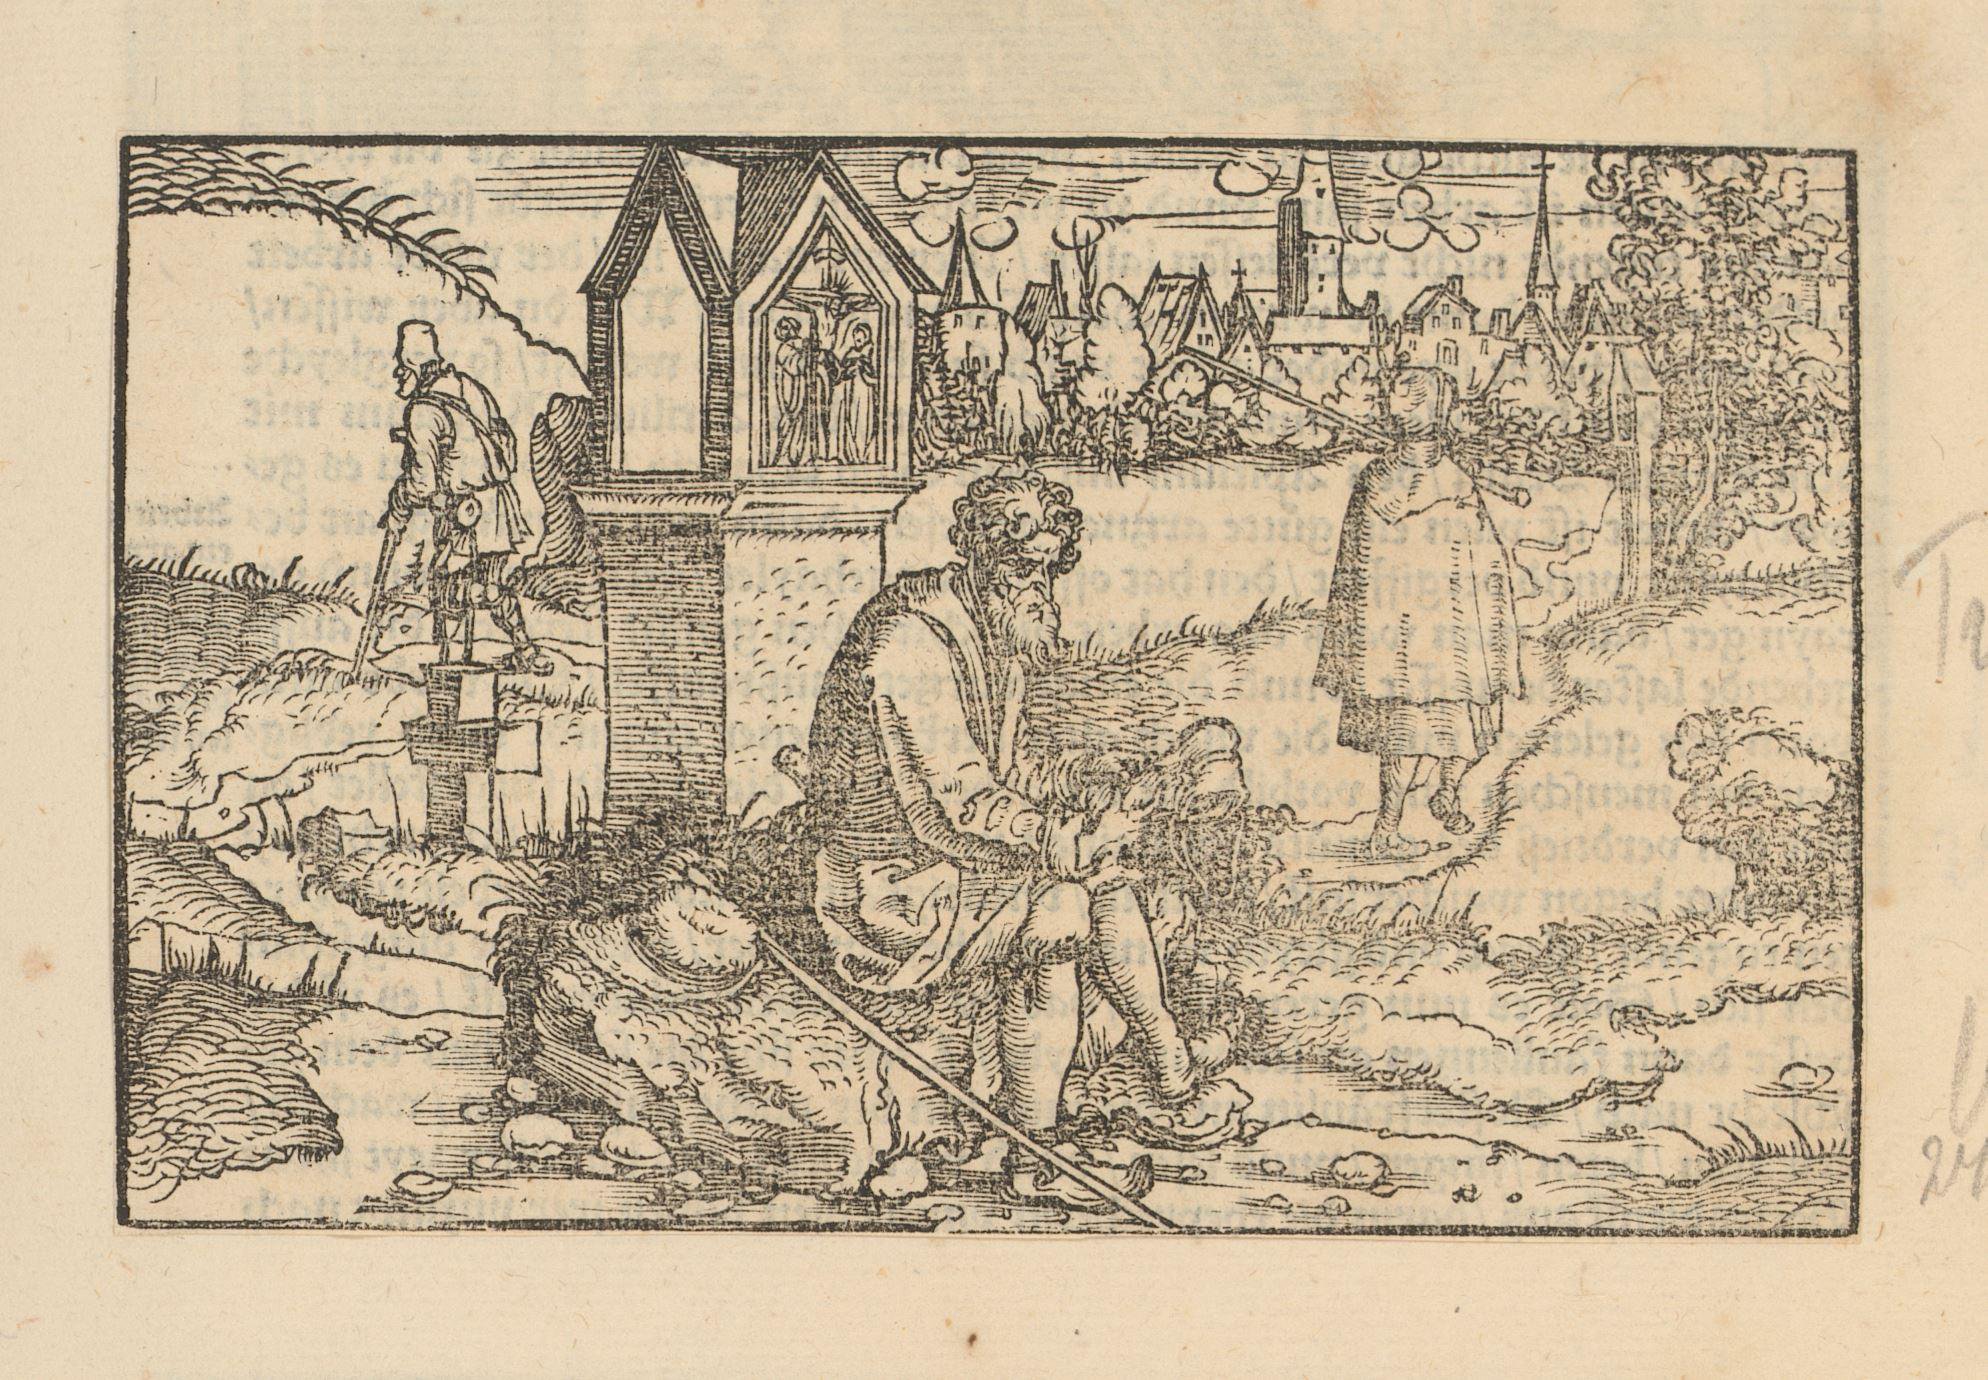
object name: album leaf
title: Reiziger bij een schrijn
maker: Anonymous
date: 1514-1532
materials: paper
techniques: letterpress printing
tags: (traveller) resting in the open air, 'en route', traveller under way, road side shrine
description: Deze prent is gebruikt in: Petrarca, Francesco. Von der Artzney bayder Glück, des guten und widerwertigen: unnd weß sich ain yeder inn Gelück und Unglück halten sol (...). Augsburg: Heinrich Steiner, 1532. Deze uitgave is ook bekend onder de titel 'Trostspiegel in Glück und Unglück'.